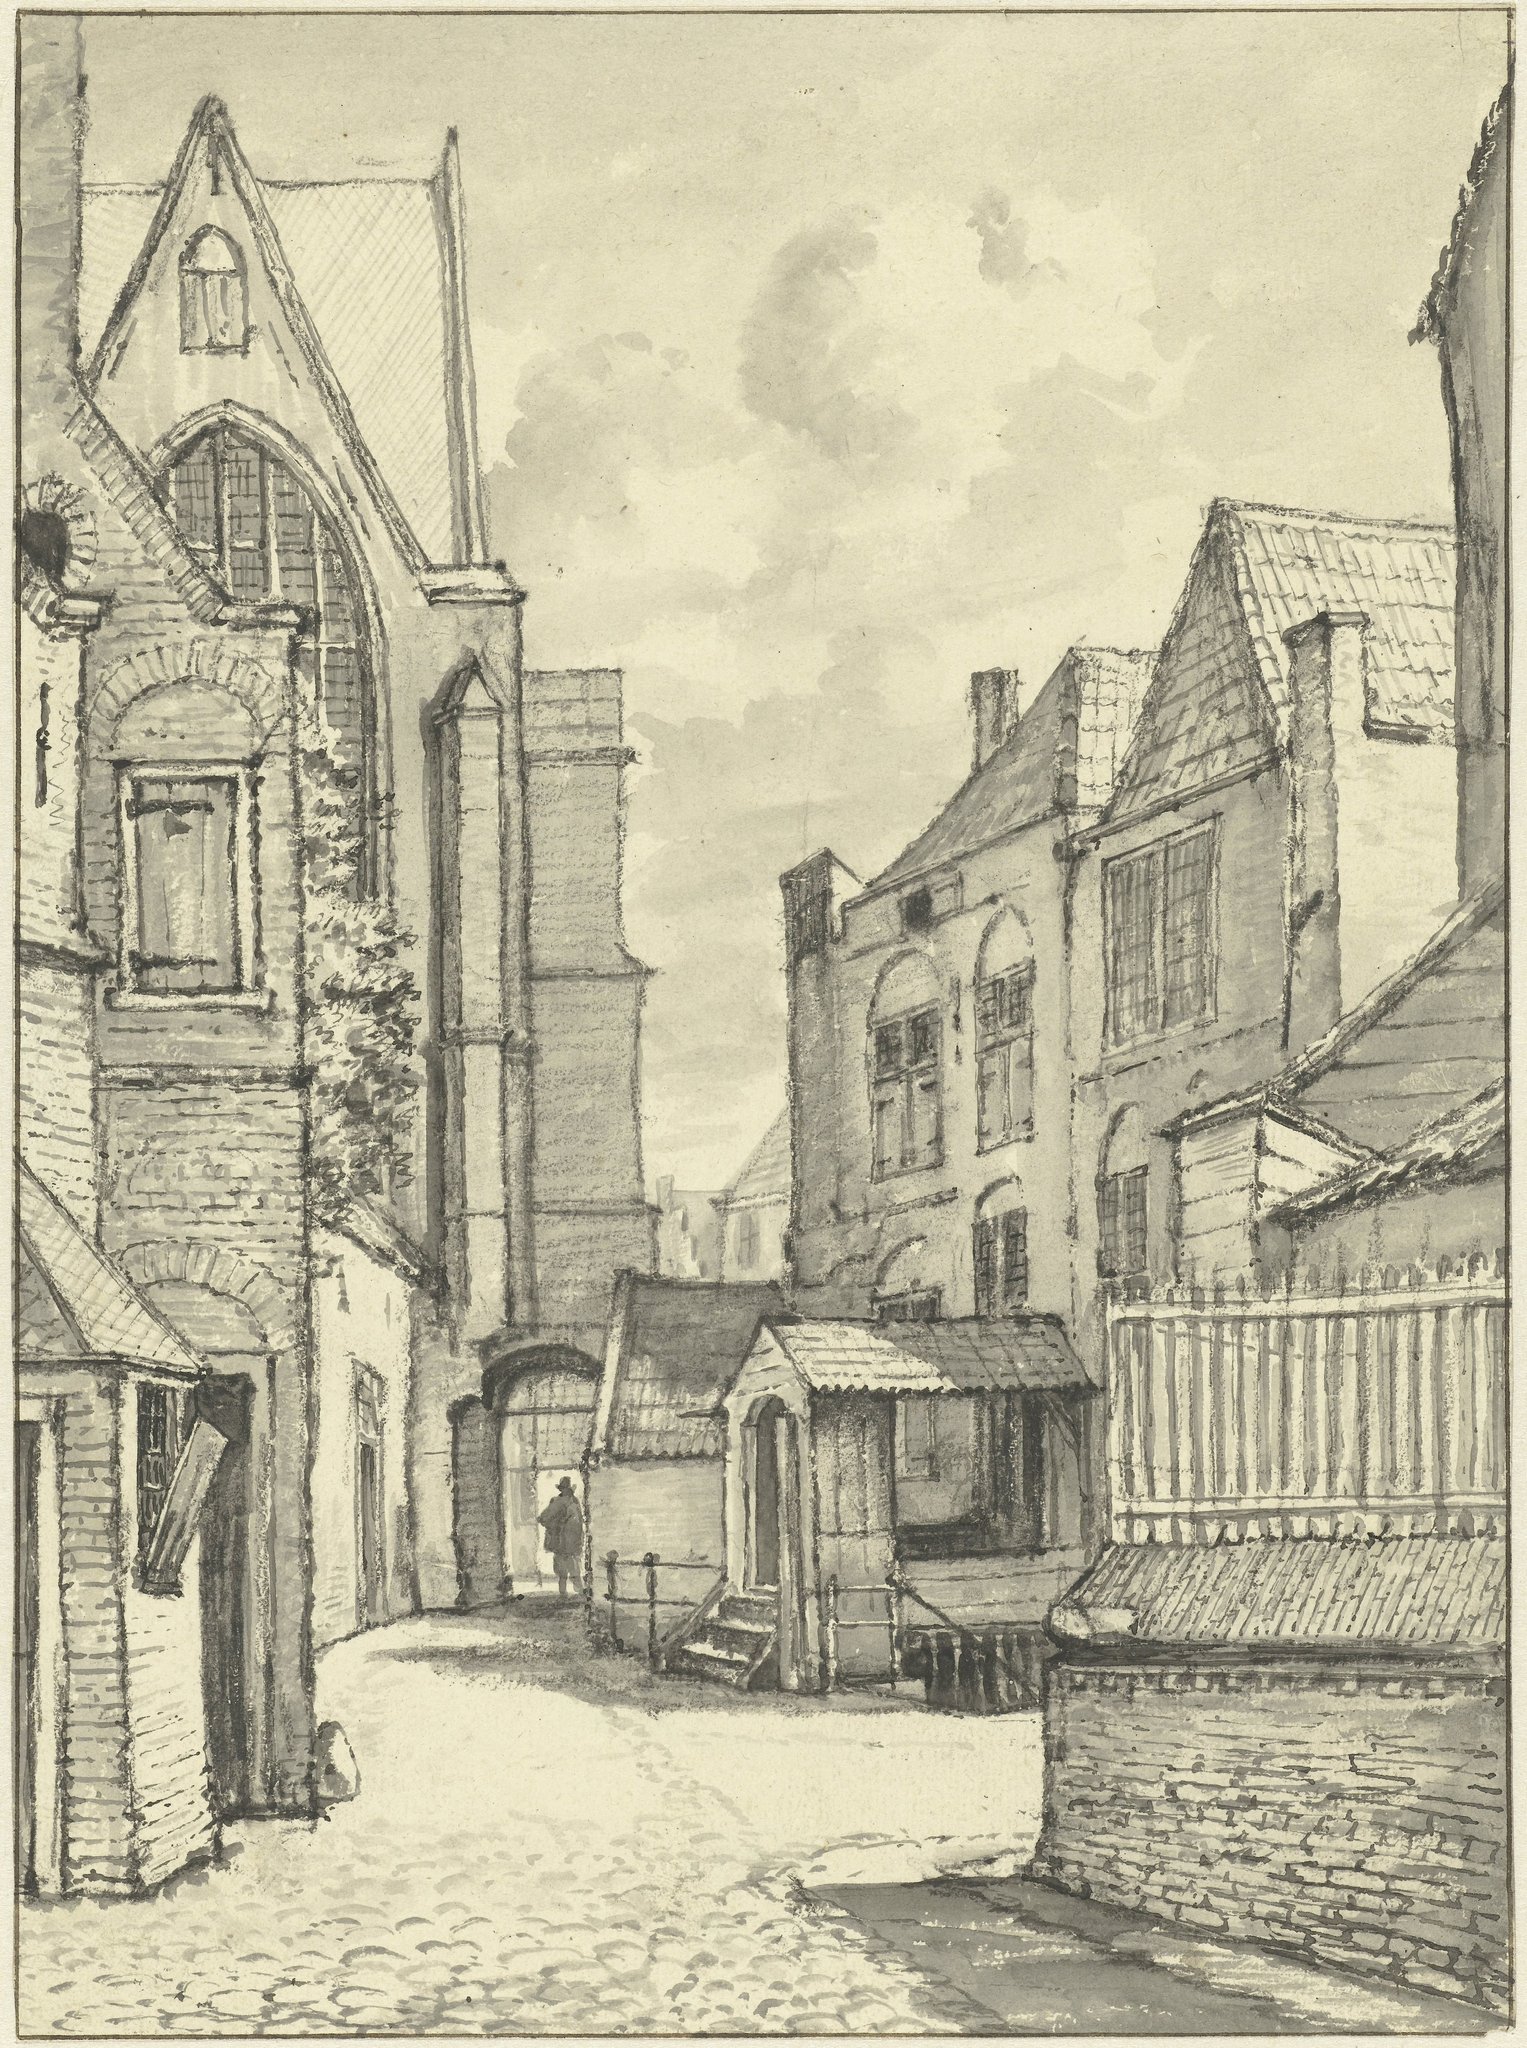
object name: drawing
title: De St. Janskerk of Grote Kerk te Gouda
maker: gerrit lamberts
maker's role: bookseller, draughtsman, print maker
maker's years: 1776-1850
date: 1786-1850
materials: chalk, ink, paper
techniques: brush, pen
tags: church (exterior), gouda